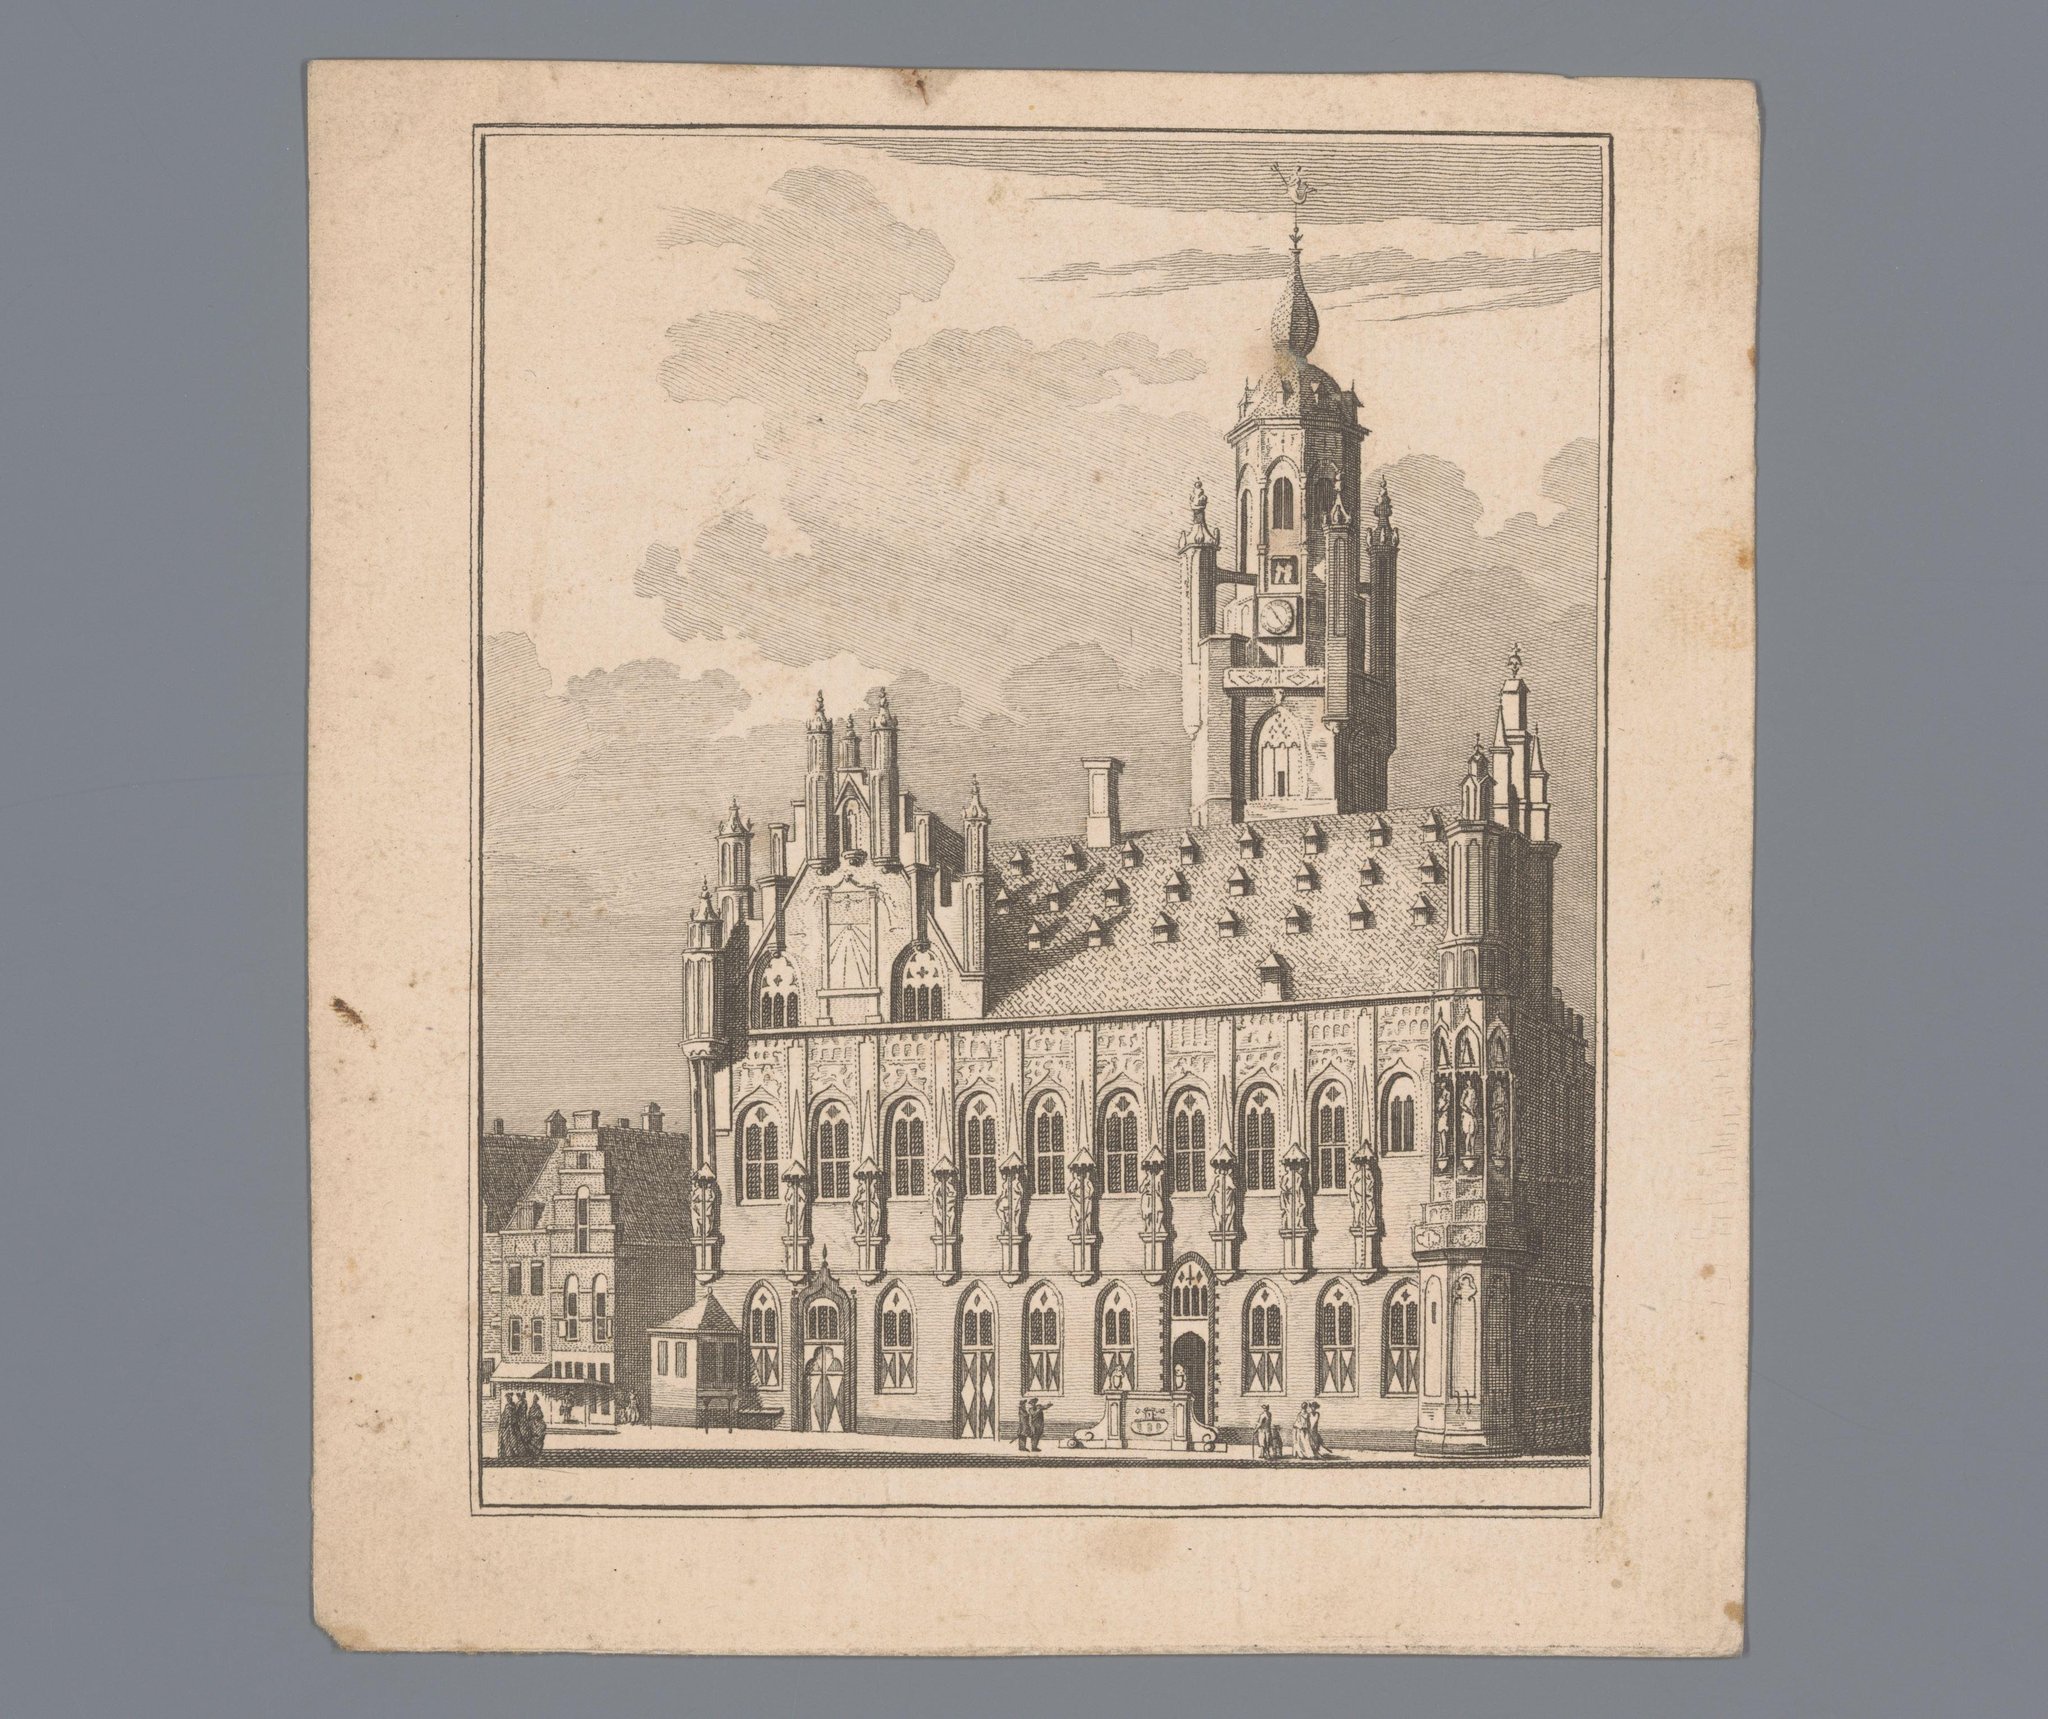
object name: print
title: Gezicht op het Stadhuis te Middelburg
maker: Anonymous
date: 1750-1800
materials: paper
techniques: etching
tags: townhall